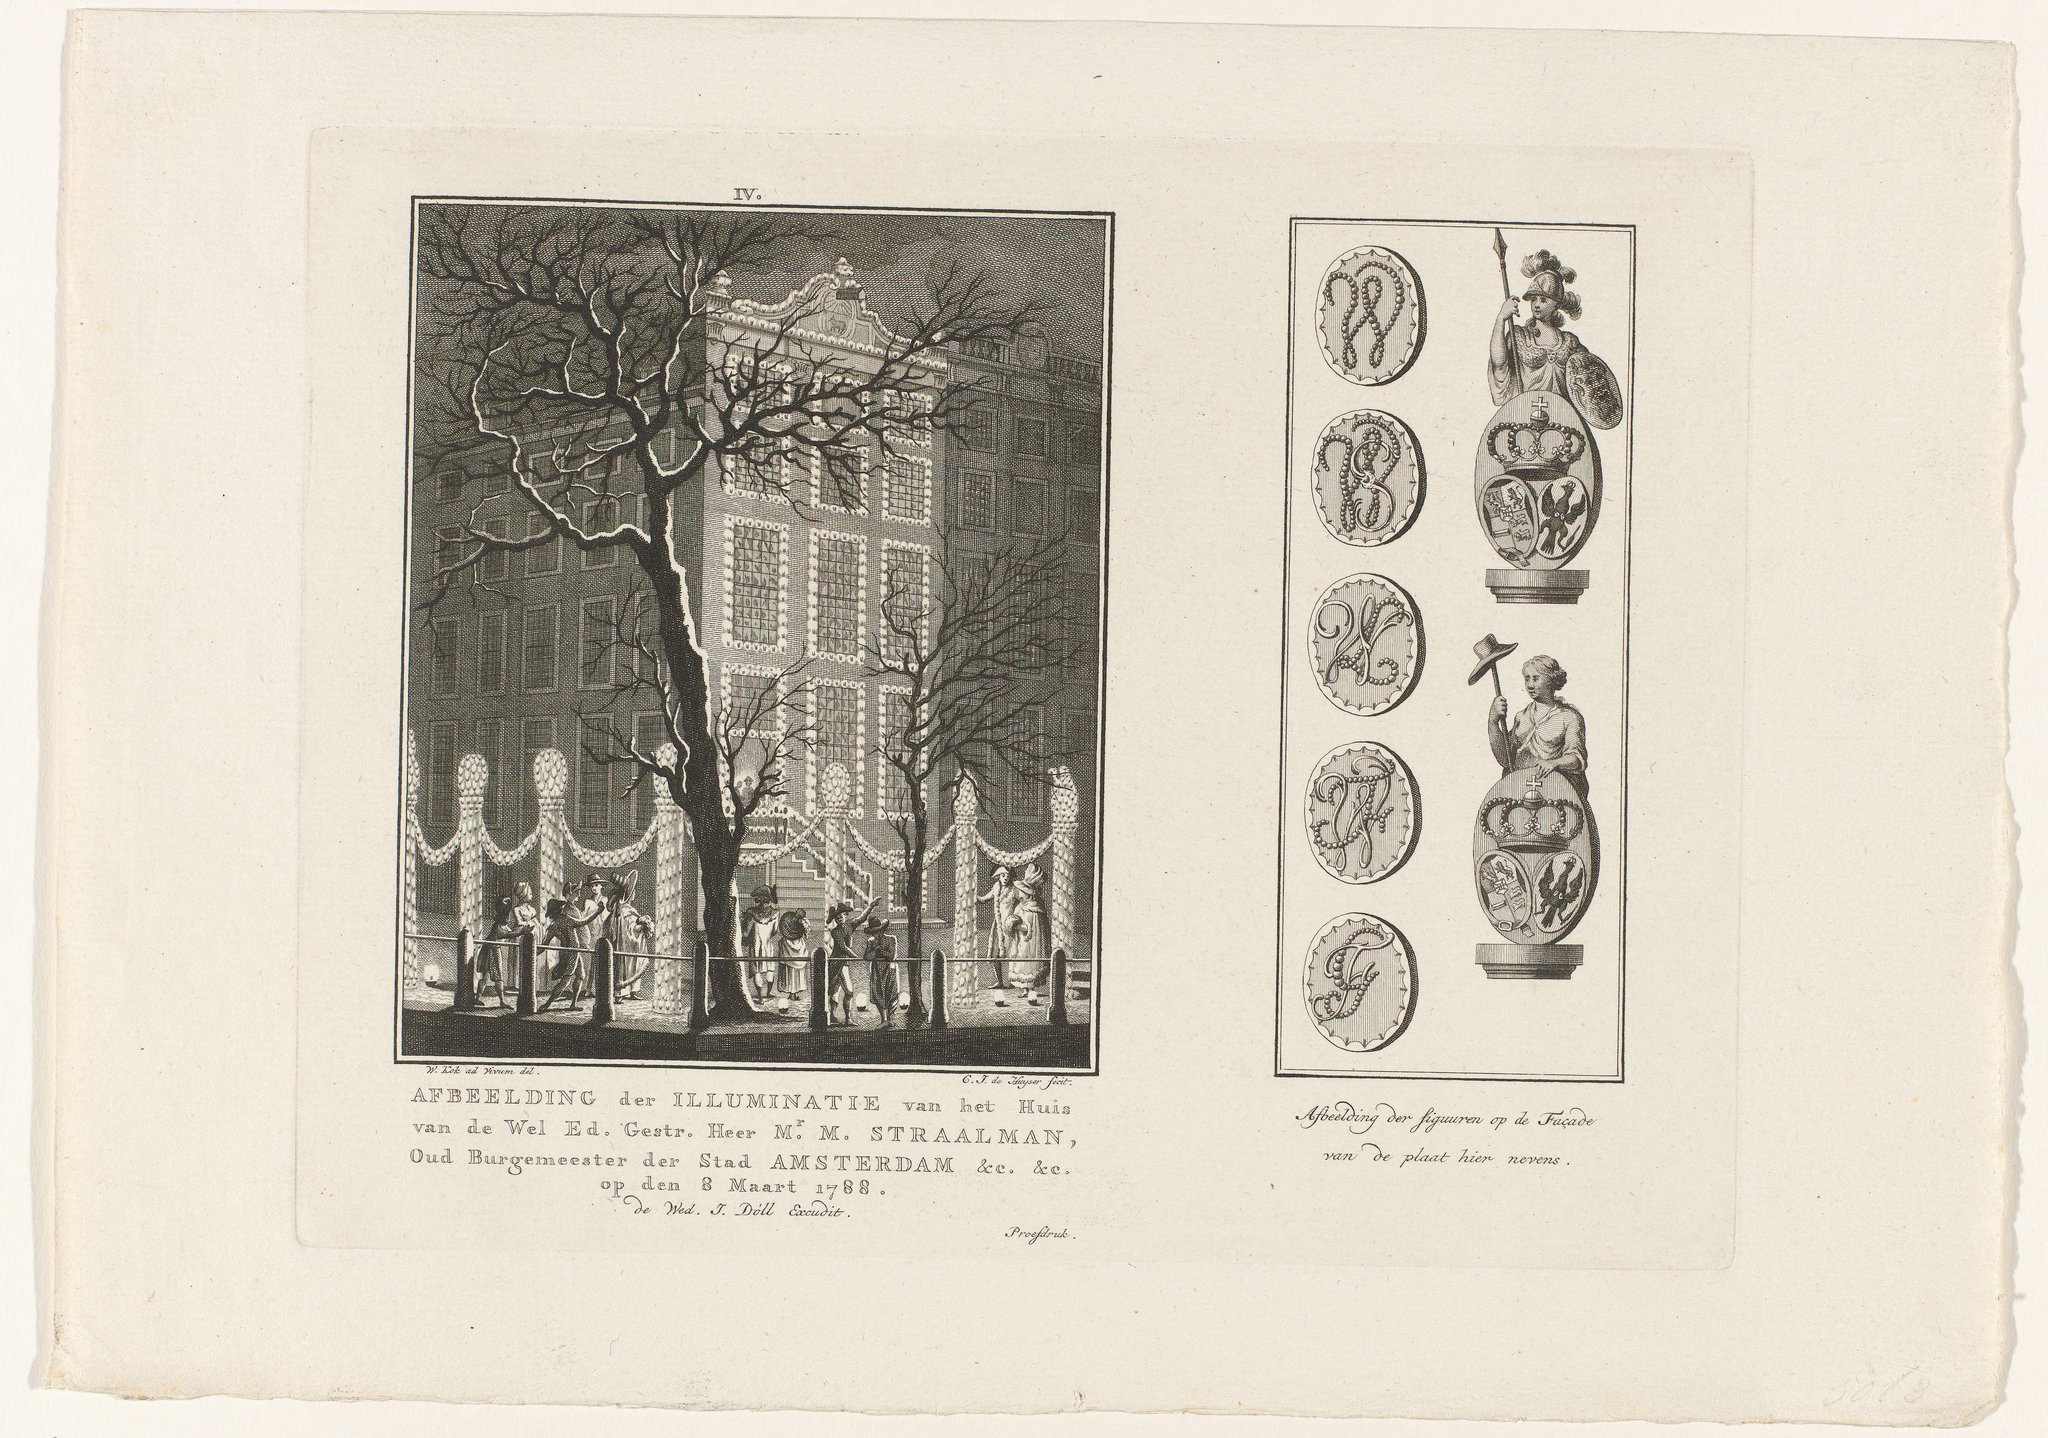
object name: print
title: Illuminatie van het huis van mr. M. Straalman te Amsterdam, 1788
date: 1788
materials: paper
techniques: engraving, etching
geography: amsterdam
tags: the hague, william v (prince of orange), mayor, matthys straalman, bonfire, fire-works (+ illumination, fire-works ~ festive activities), amsterdam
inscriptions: collector's mark: Lugt 2228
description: Illuminatie aangebracht op de gevel van en voor het huis van mr. Matthys Straalman, oud-burgemeester te Amsterdam. Met details van de figuren in de decoraties. Genummerd bovenaan: IV. Onderdeel van een reeks van twaalf platen van de illuminaties en decoraties te Amsterdam op de 40ste verjaardag van prins Willem V op 8 maart 1788.